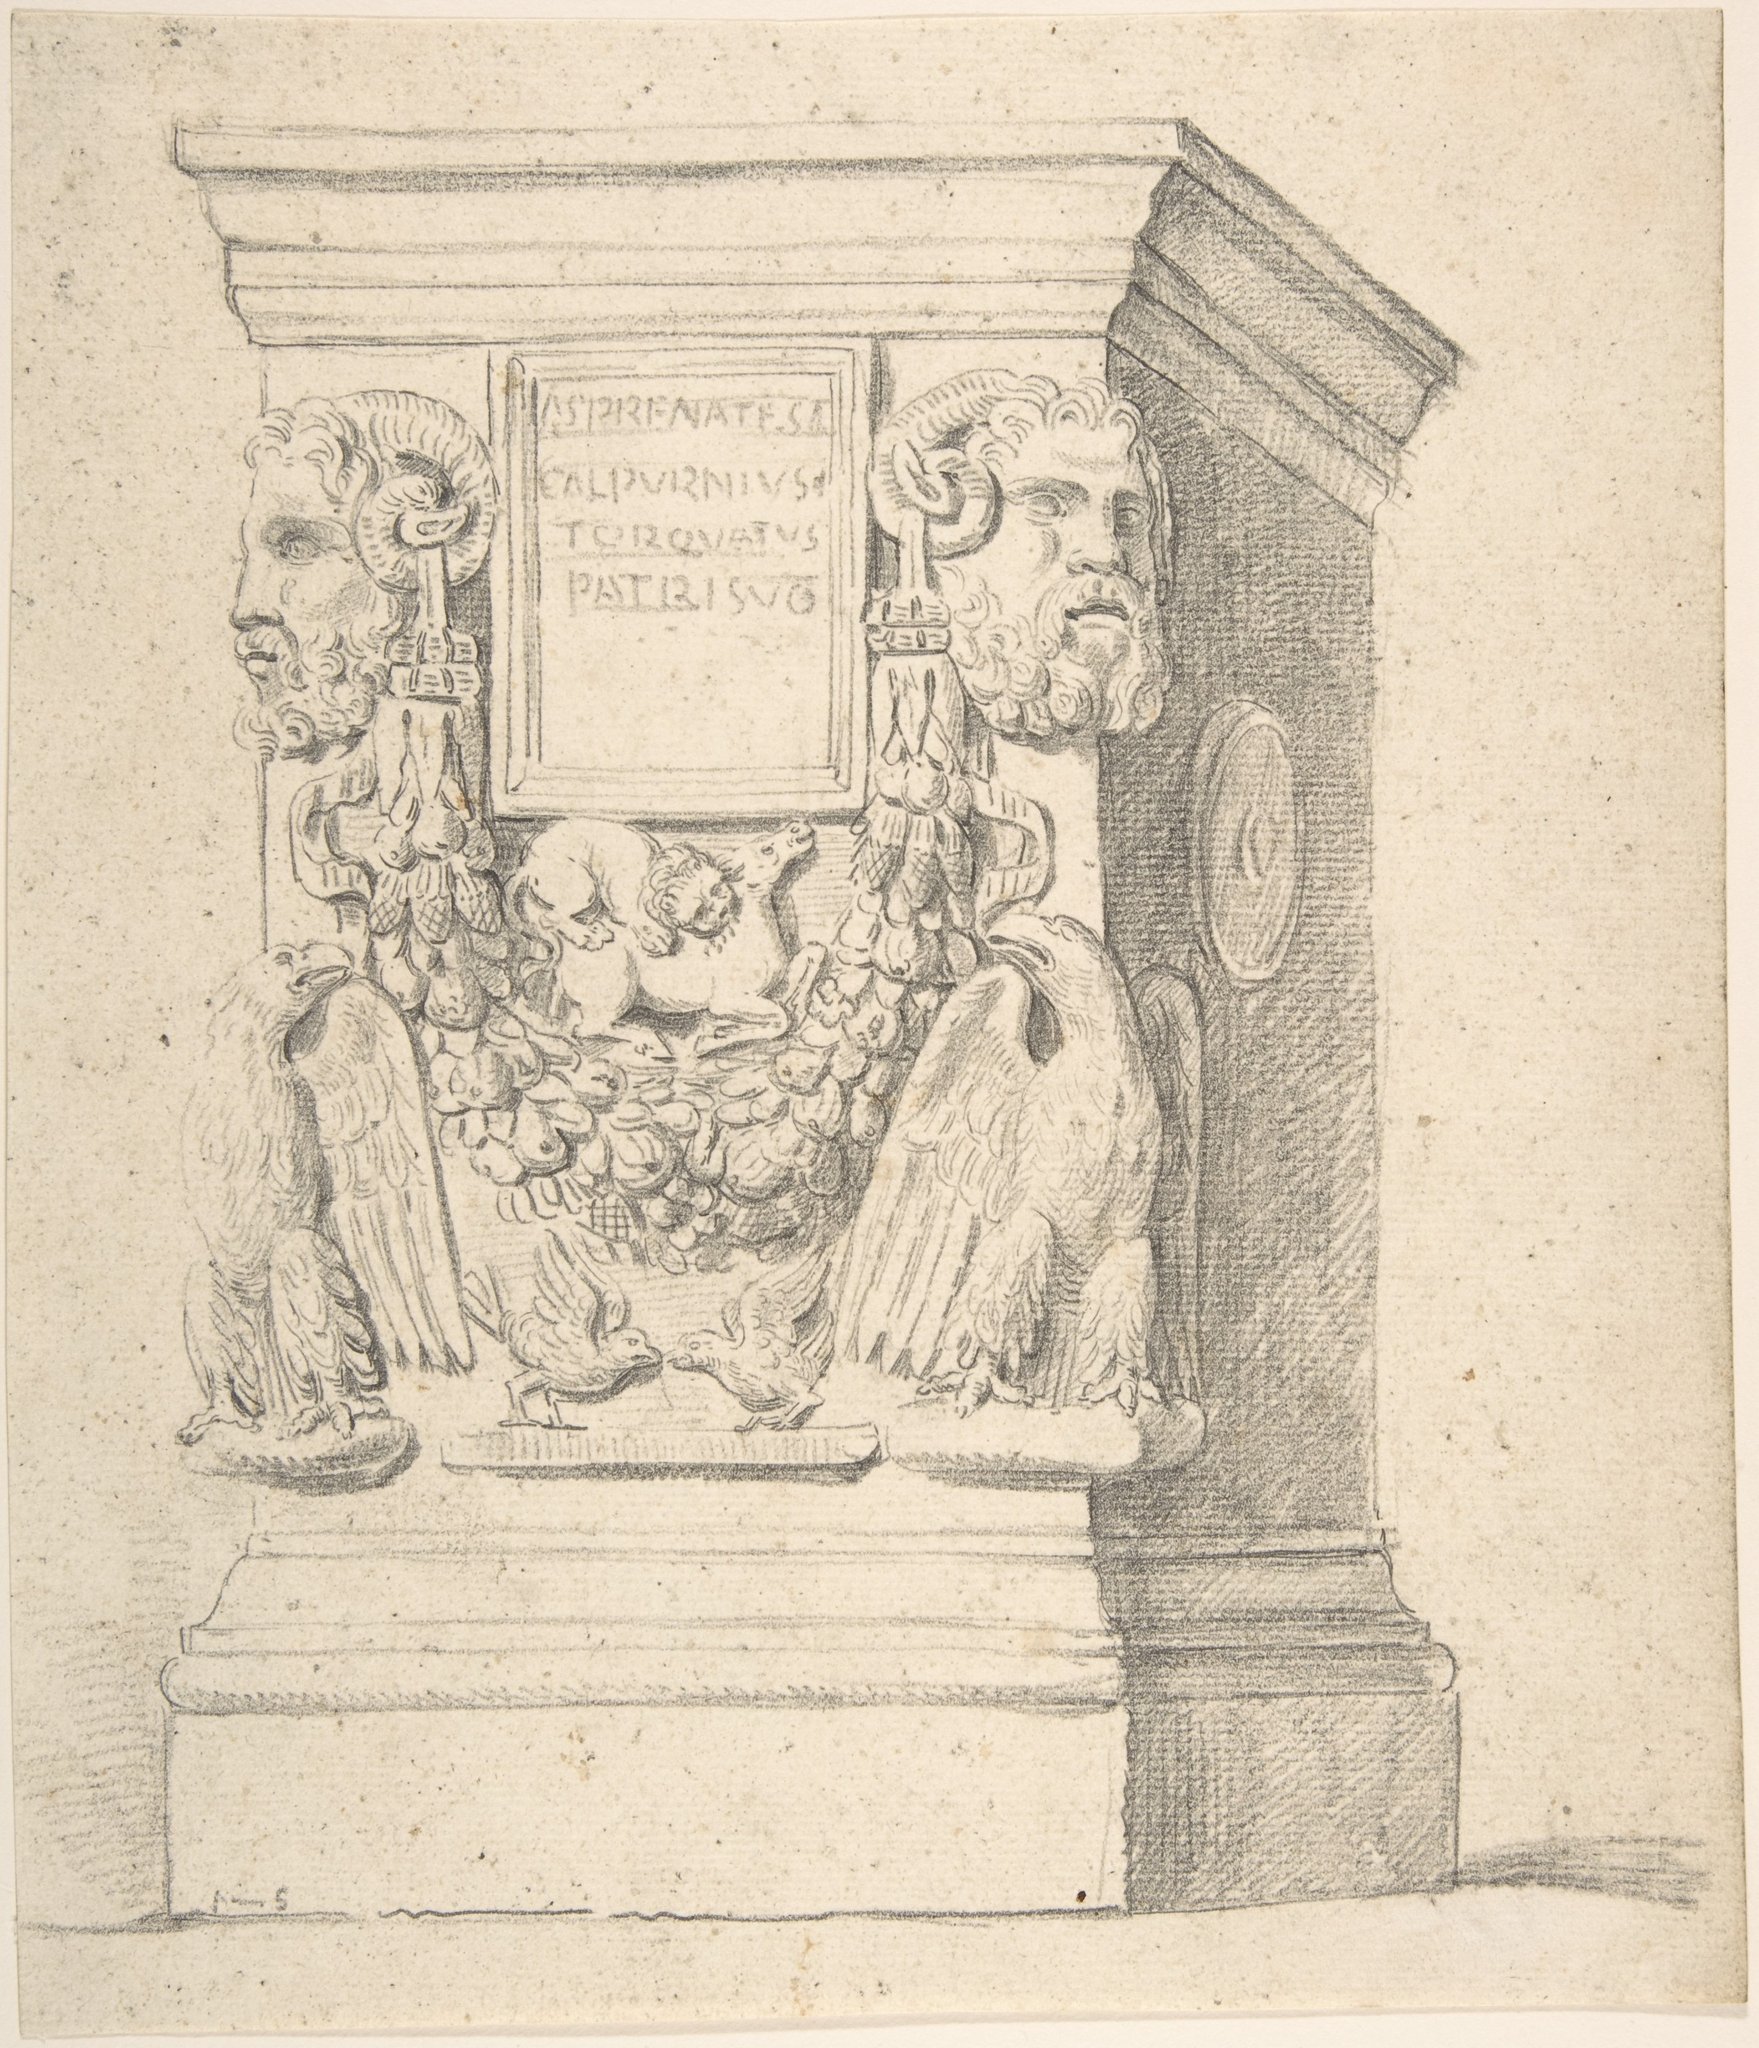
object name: drawing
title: Sketch of a Classical Pedestal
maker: thomas hardwick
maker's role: artist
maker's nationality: british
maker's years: 1752-1829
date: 1776-1779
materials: graphite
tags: eagles,architecture,faces